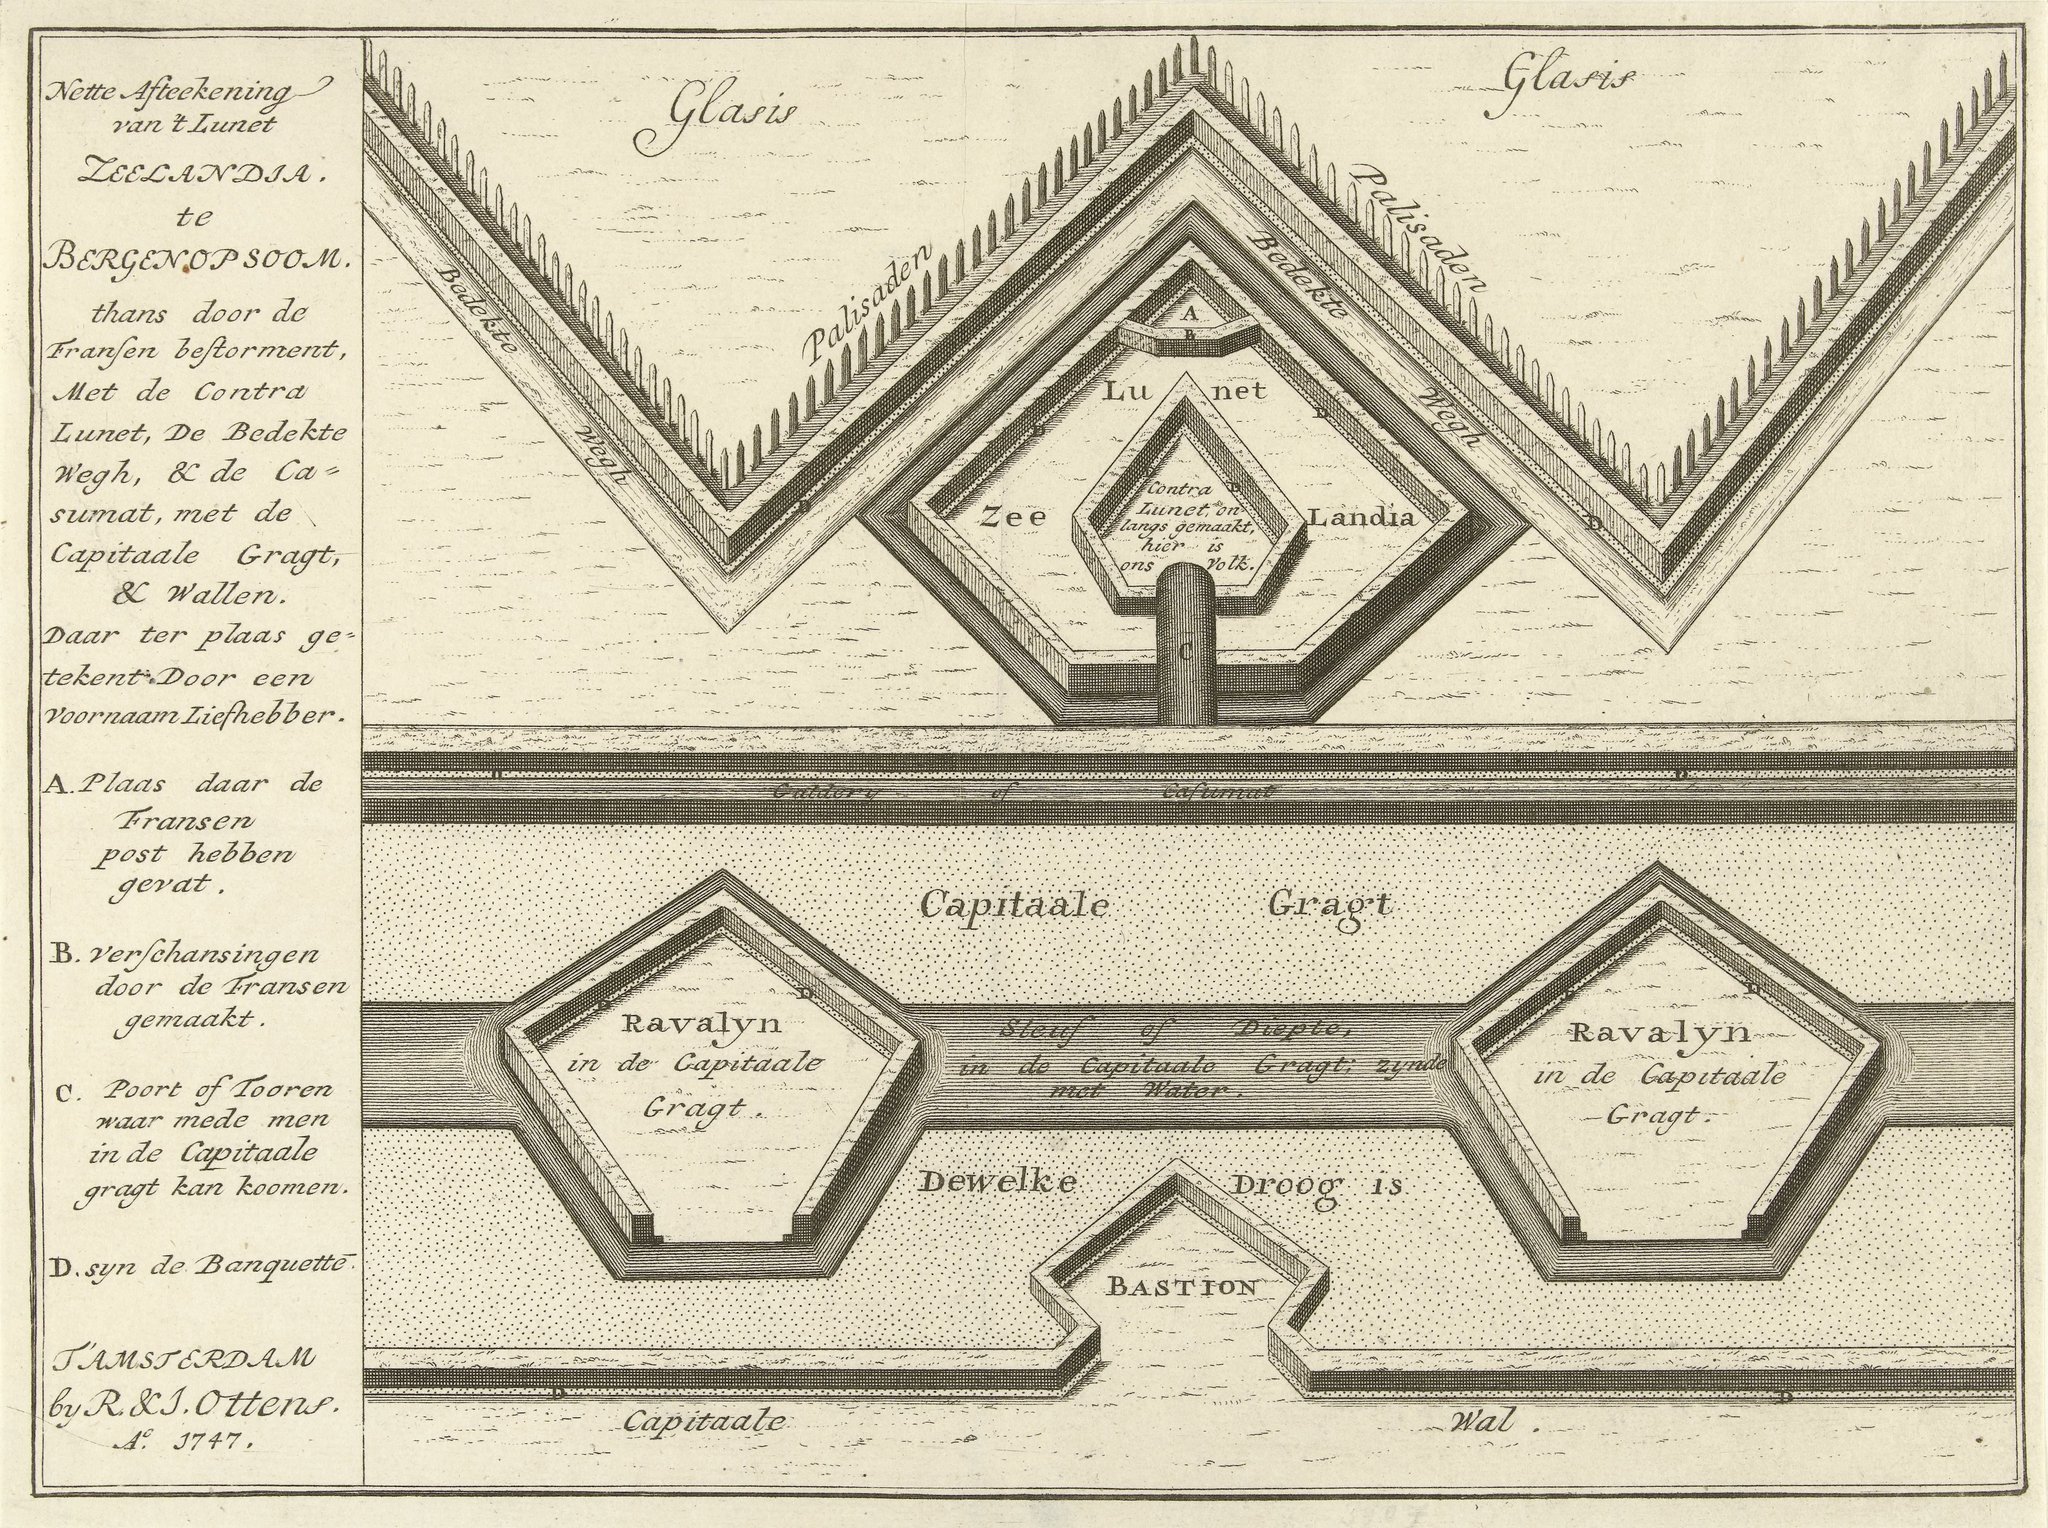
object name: print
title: Lunet Zeelandia in de vesting van Bergen op Zoom, 1747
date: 1747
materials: paper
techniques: etching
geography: bergen op zoom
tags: fortress, bergen op zoom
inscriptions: collector's mark: Lugt 2228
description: Schematische vooorstelling van de lunet Zeelandia in de vesting van Bergen op Zoom, met de bijbehorende bastion, ravelijnen, bedekte weg, glacis, kazemat en gracht, ten tijde van het beleg door de Fransen juli-september 1747. Links de legenda A-D.